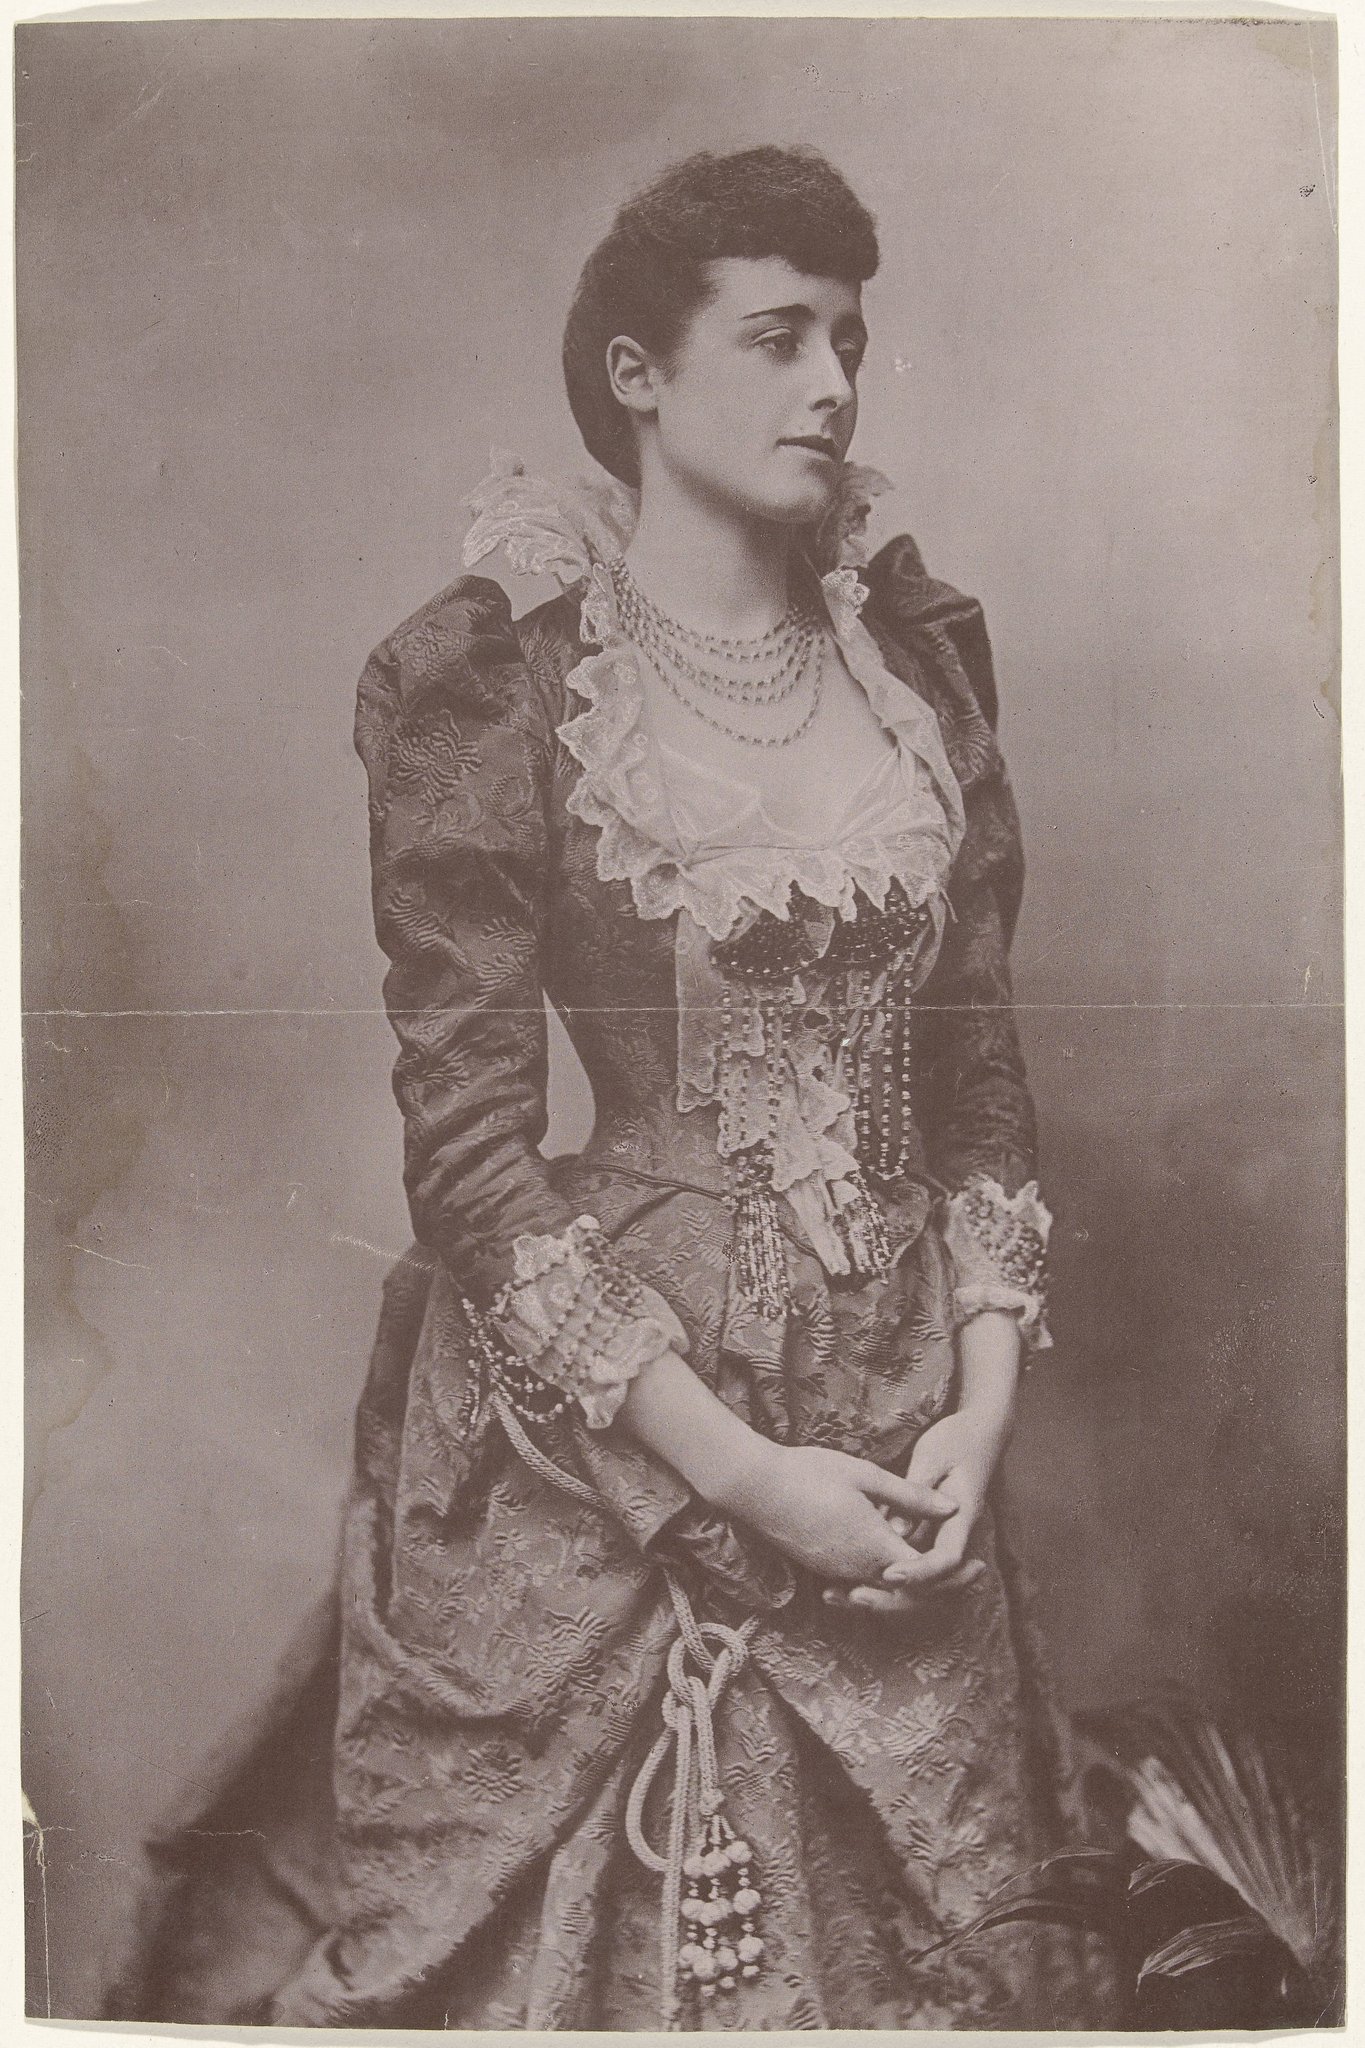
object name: photograph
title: Portret van een vrouw in luxueus kostuum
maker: Anonymous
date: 1890-1910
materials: photographic support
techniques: albumen print